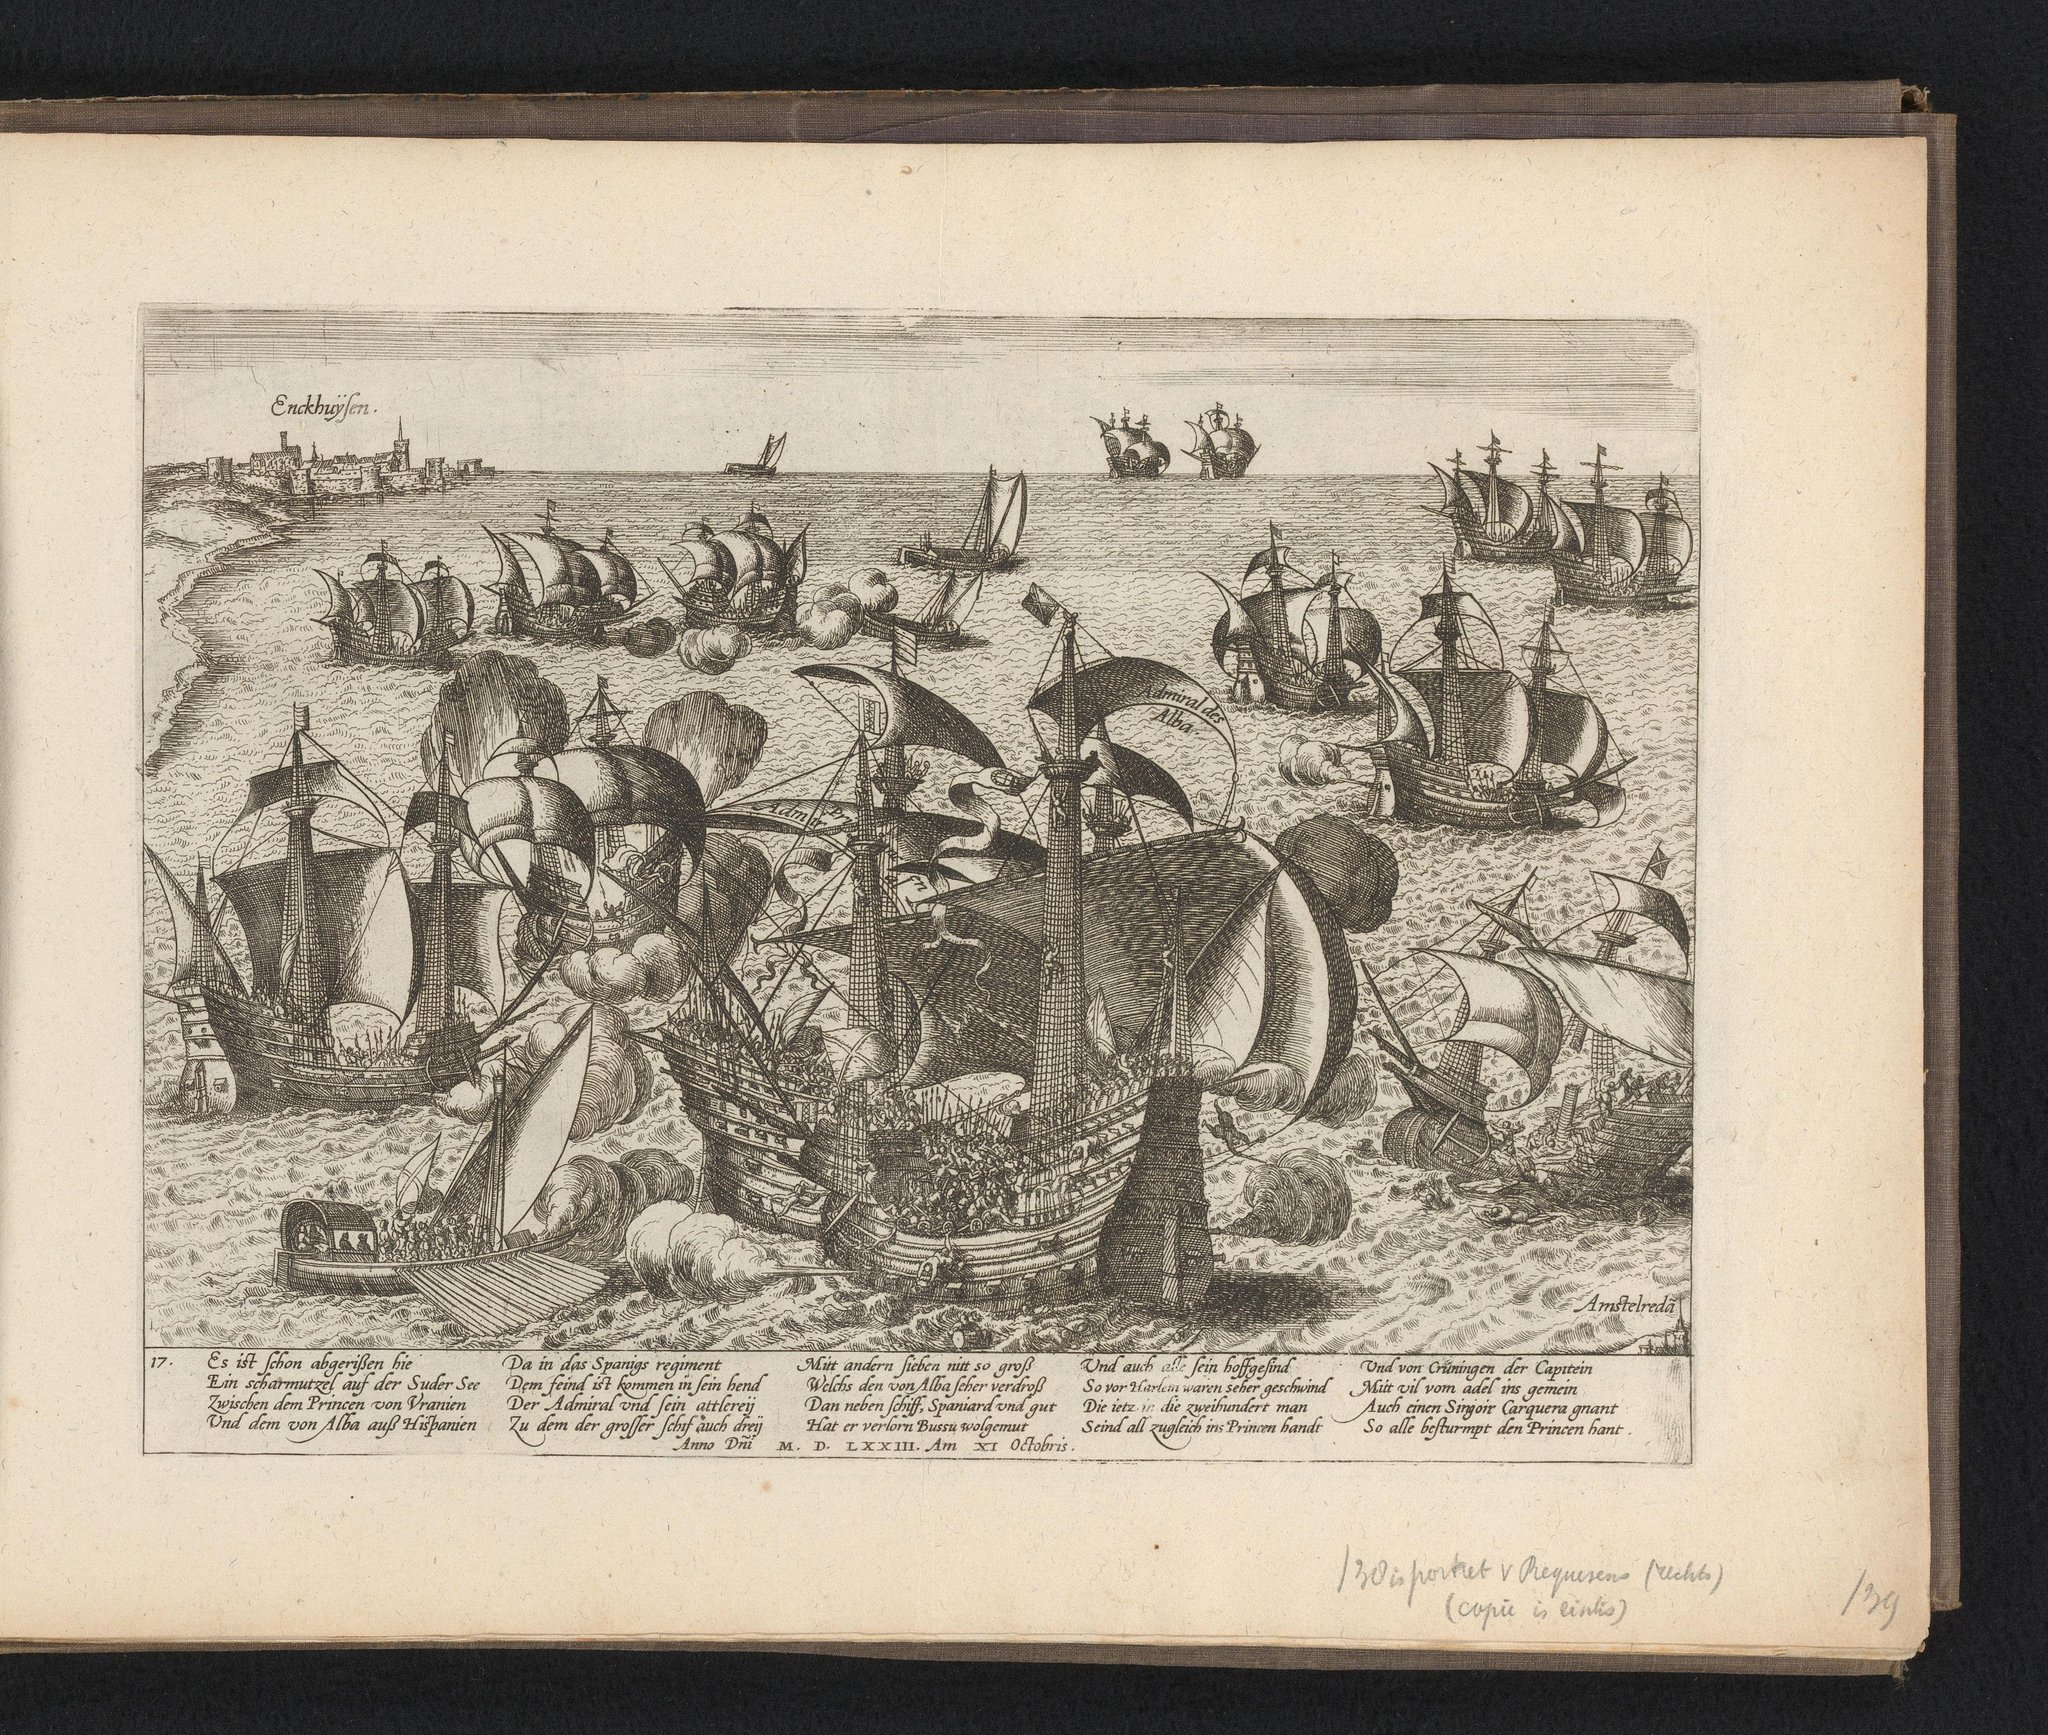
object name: album leaf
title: Folge 6: Niederländische Ereignisse der Jahre 1571-1576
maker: frans hogenberg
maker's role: print maker, publisher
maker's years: 1538-1590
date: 1573-1583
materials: paper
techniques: etching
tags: antwerp, earl, battle (+ naval force), enkhuizen, zuiderzee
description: Prent gebruikt in: Aitsinger, Michael. De Leone Belgico ejusque topographica atque historica descriptione liber (...). S.l.s.n., 1583.